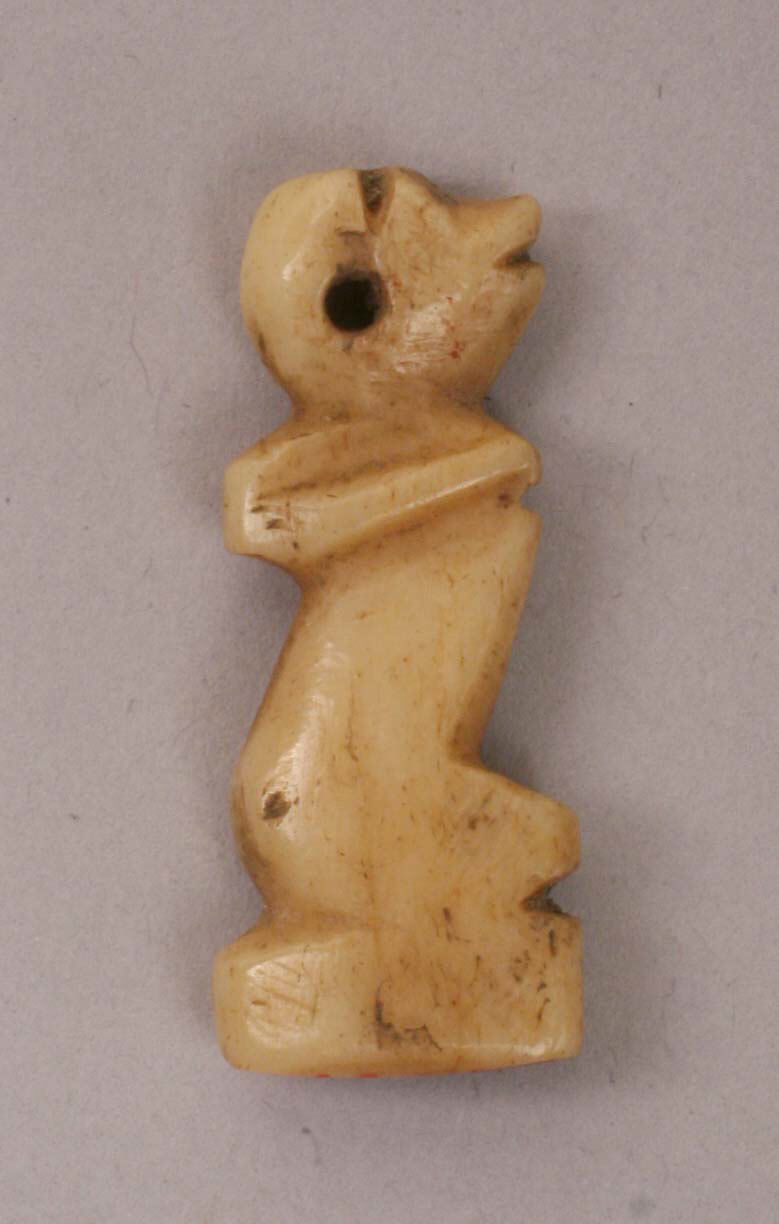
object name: necklace, bead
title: Amulet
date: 30 BCE-364 CE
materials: bone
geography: egypt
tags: amulets